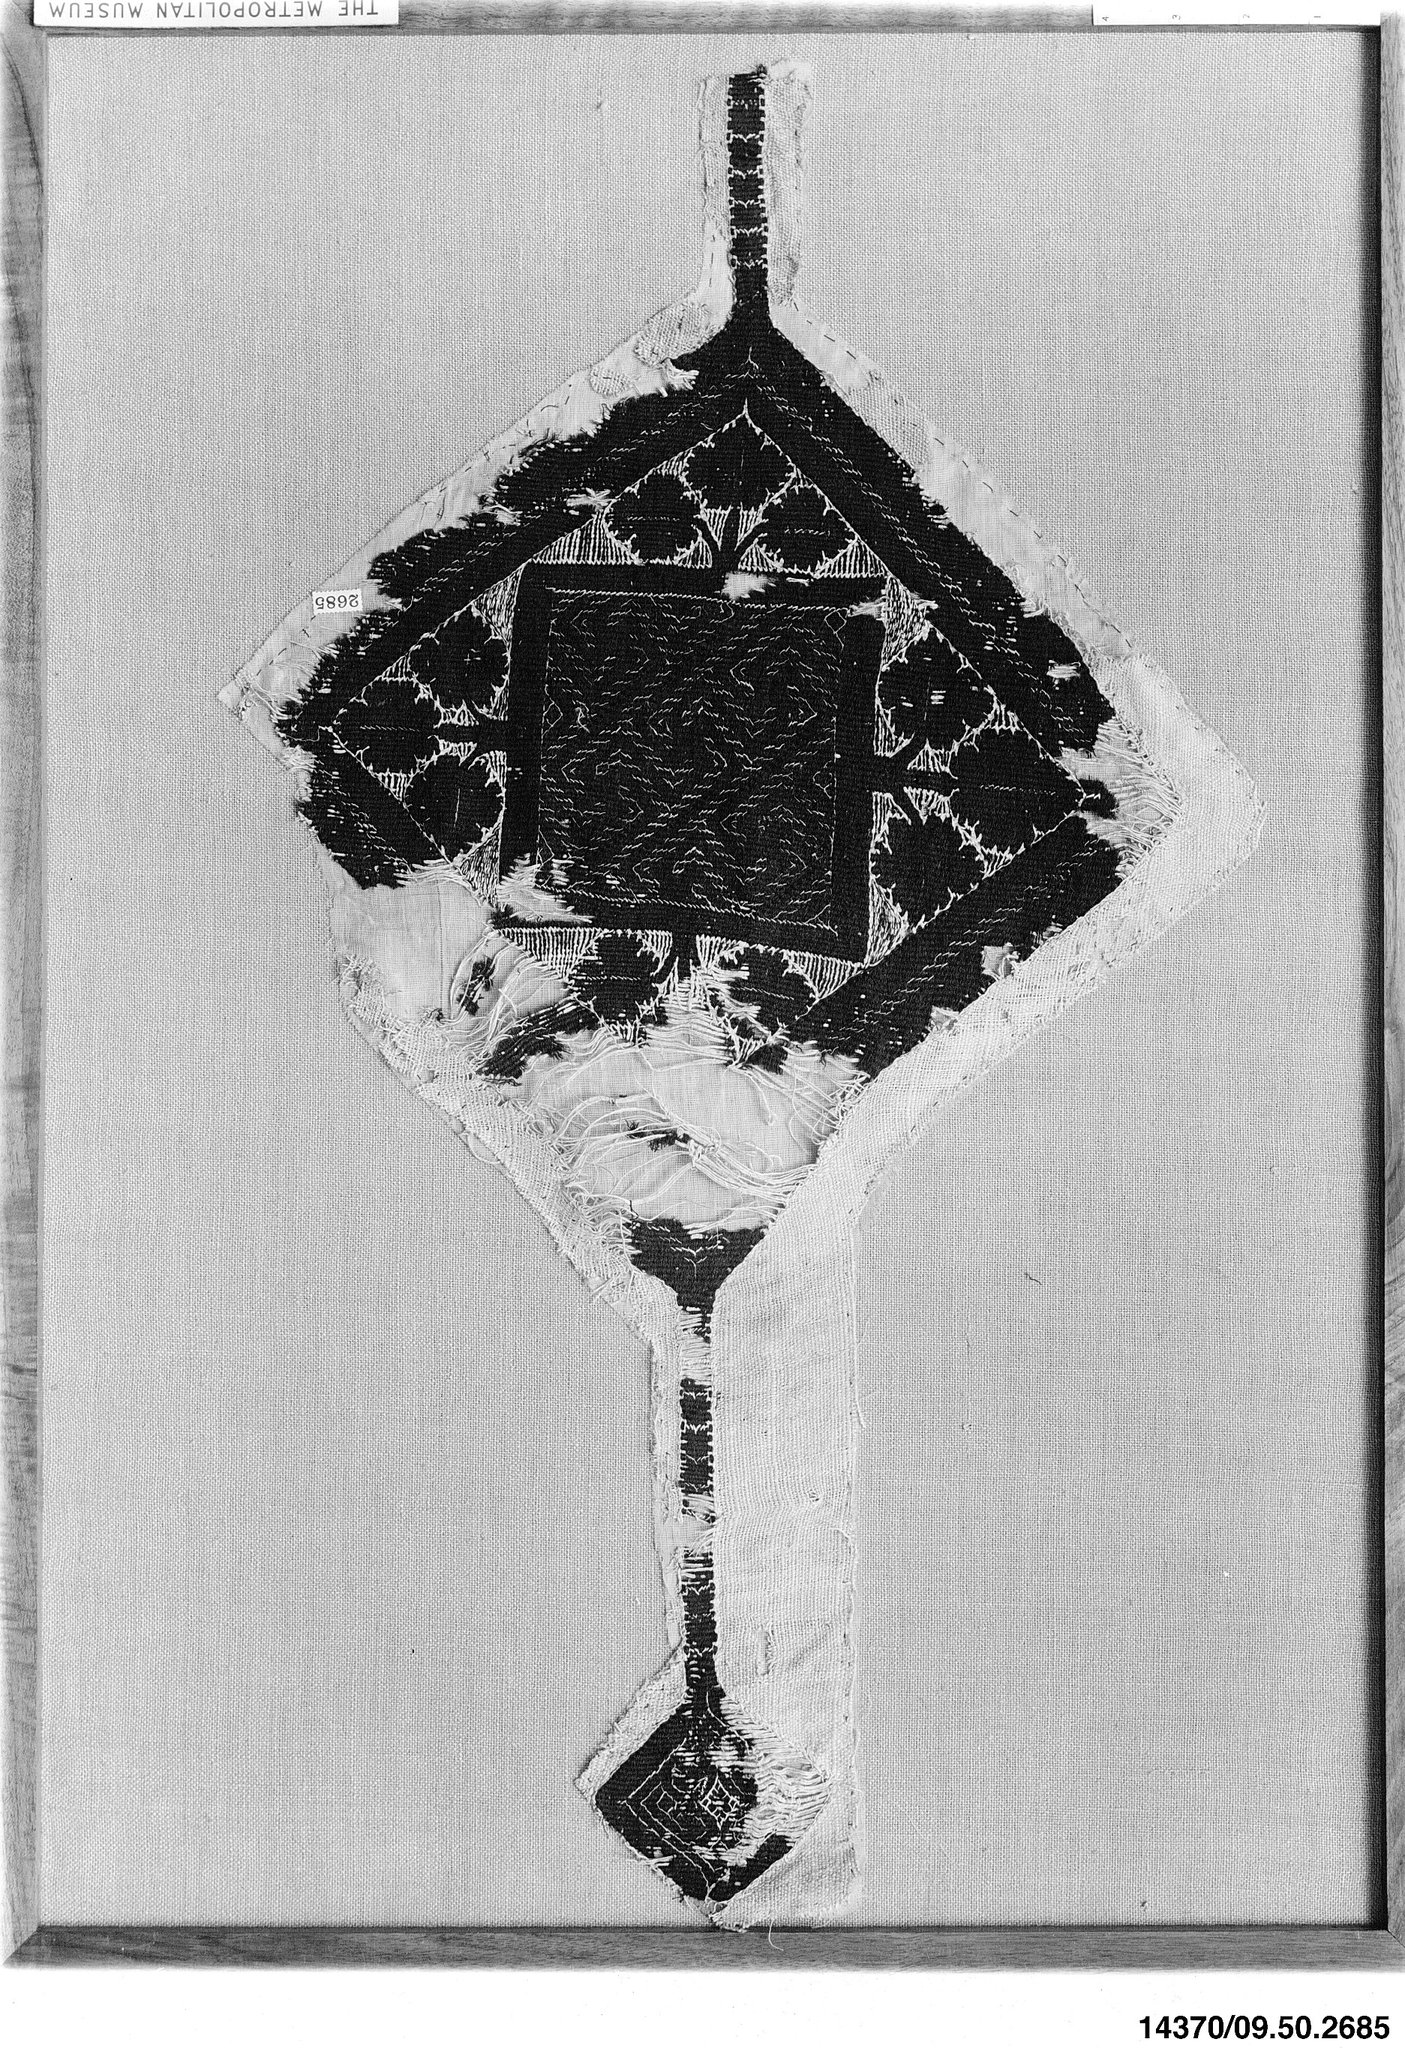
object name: panel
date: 301-400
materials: linen, wool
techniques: weave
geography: egypt